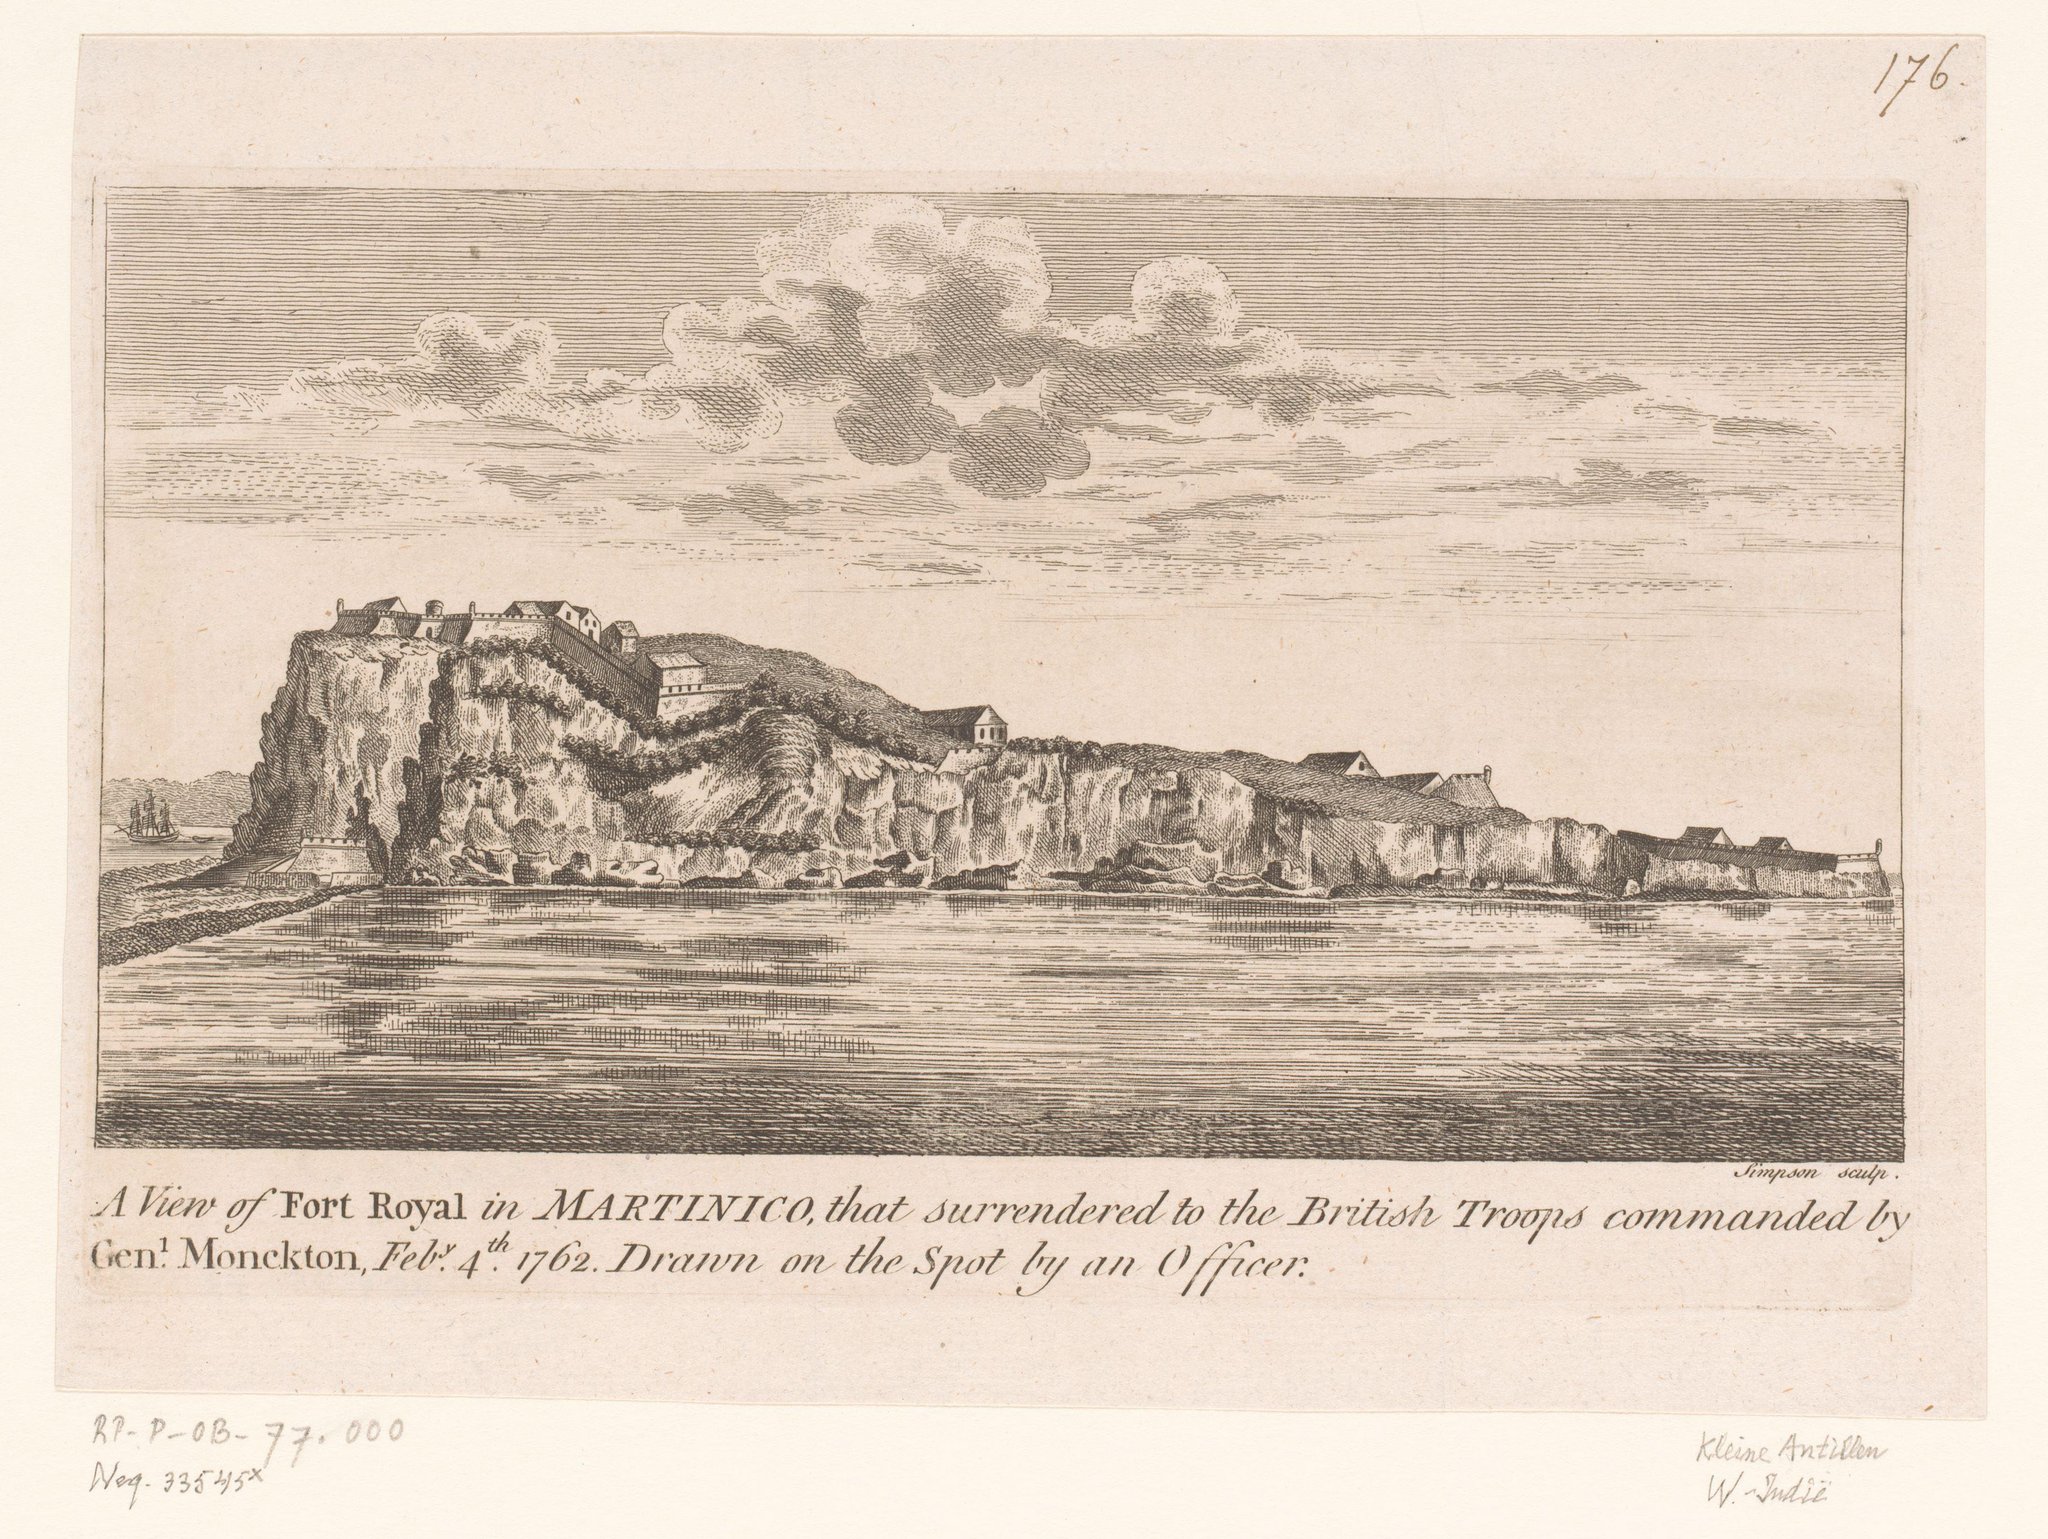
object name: print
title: A view of Fort Royal in Martinico, that surrendered to the British troops commanded by Gen. Monckton, Feb. 4th. 1762. Drawn on the spot by an officer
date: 1762-1770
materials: paper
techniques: etching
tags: fortress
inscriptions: inscription: ‘176’, collector's mark: Lugt 2228